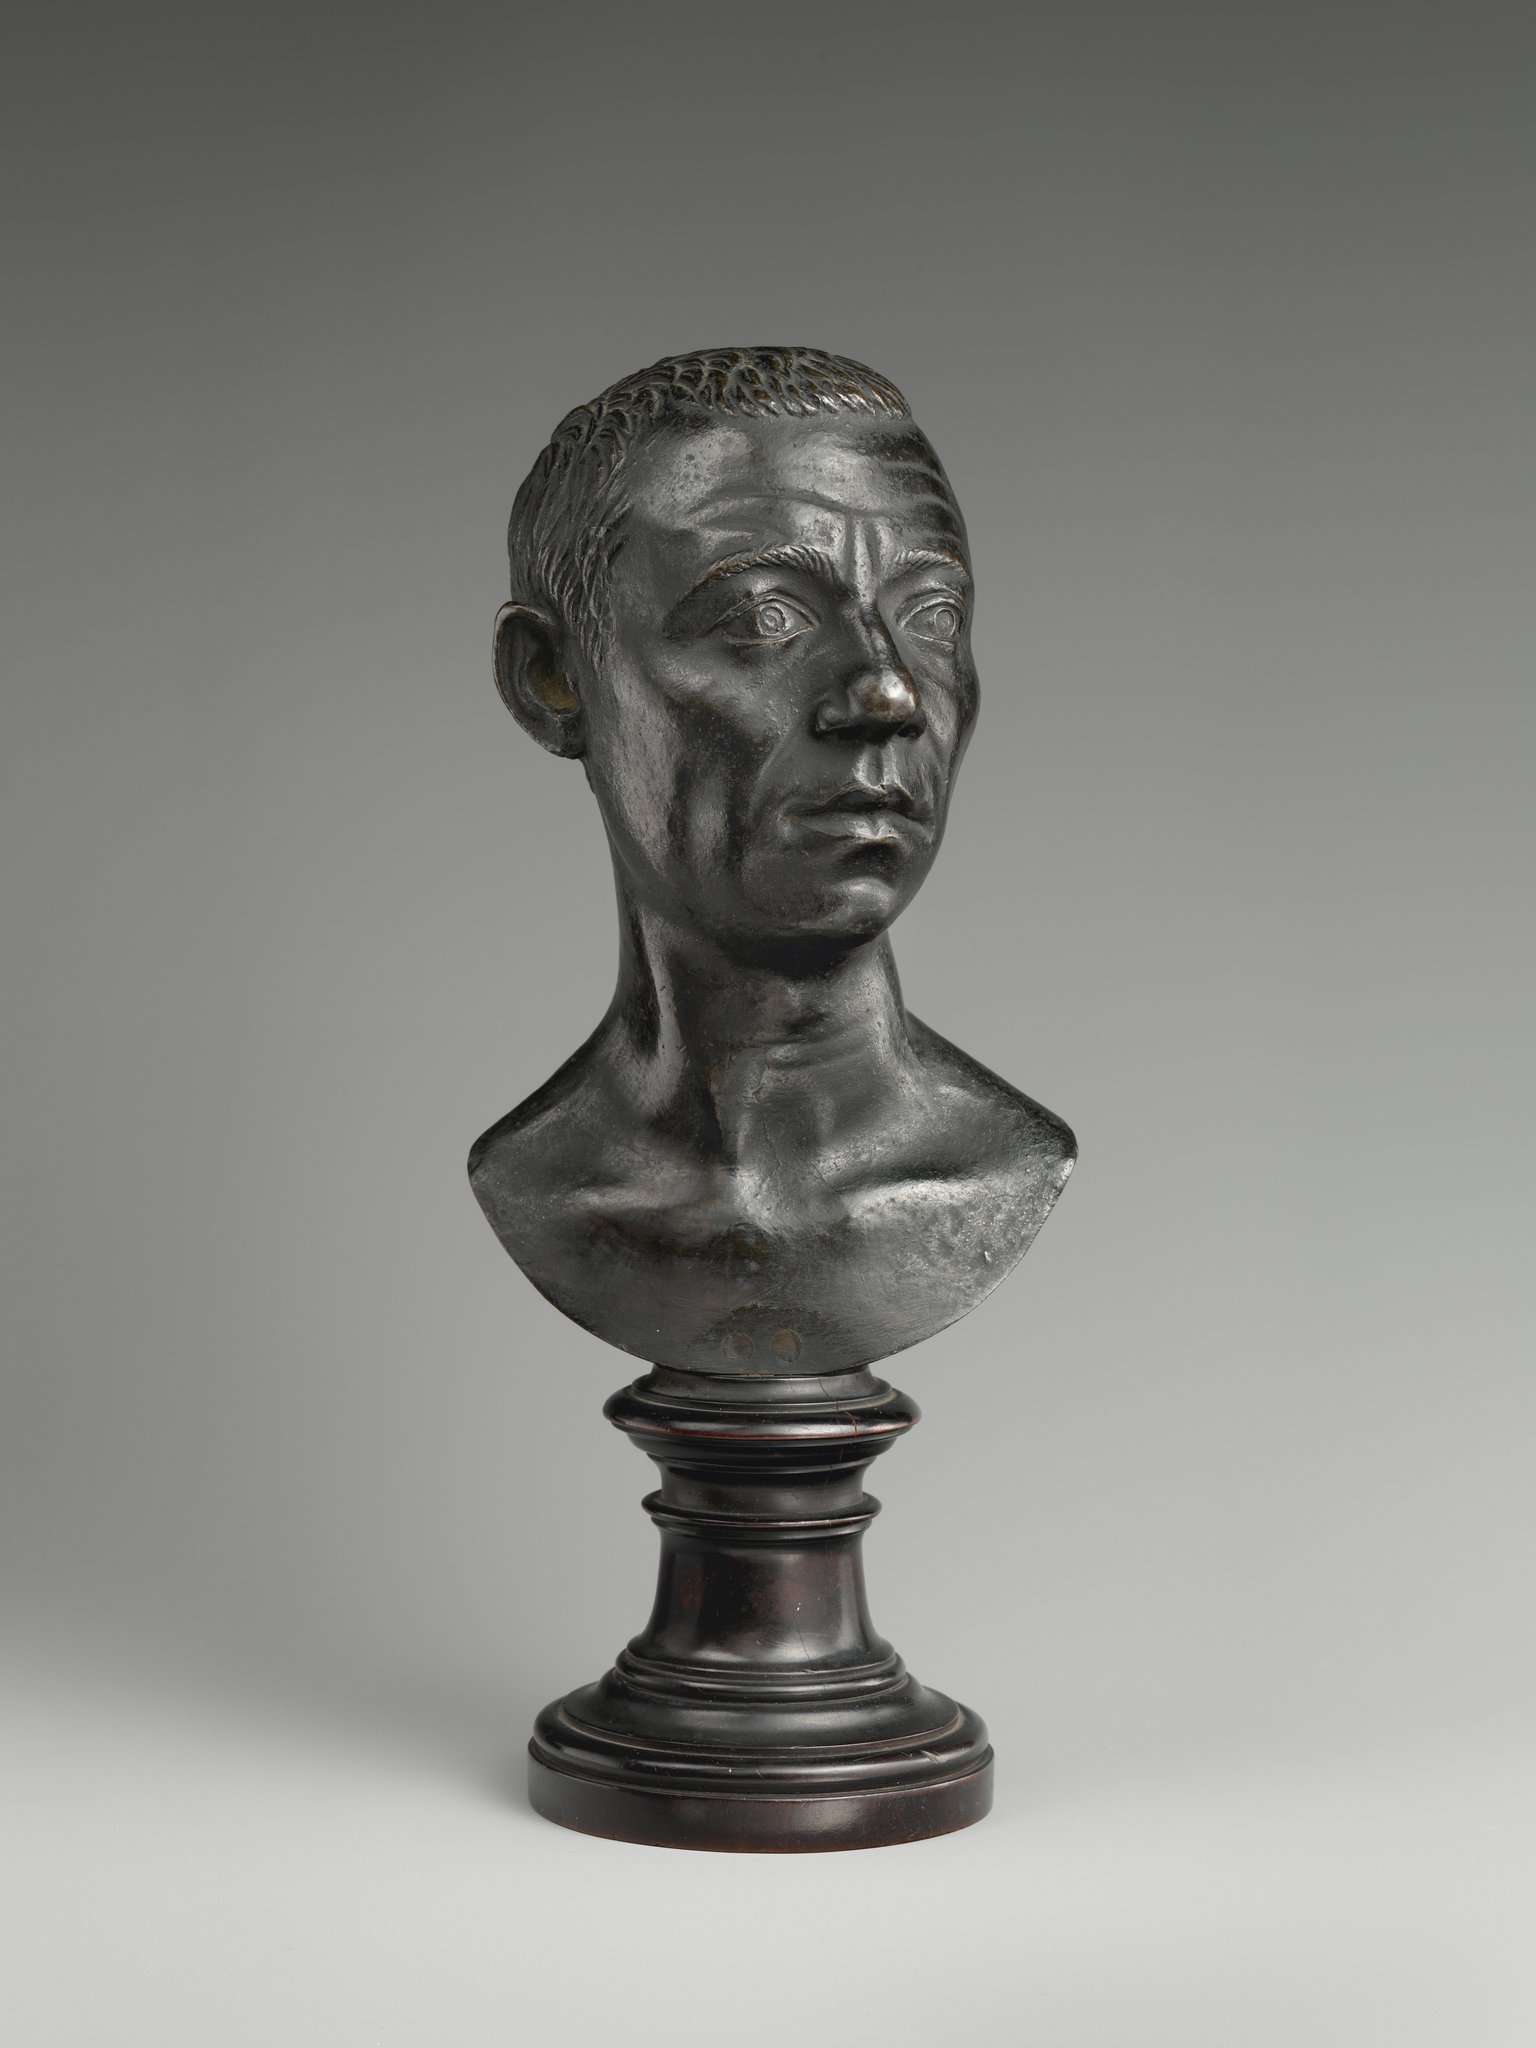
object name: bust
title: Bust of a Roman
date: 1501-1600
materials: bronze, wood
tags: men,portraits